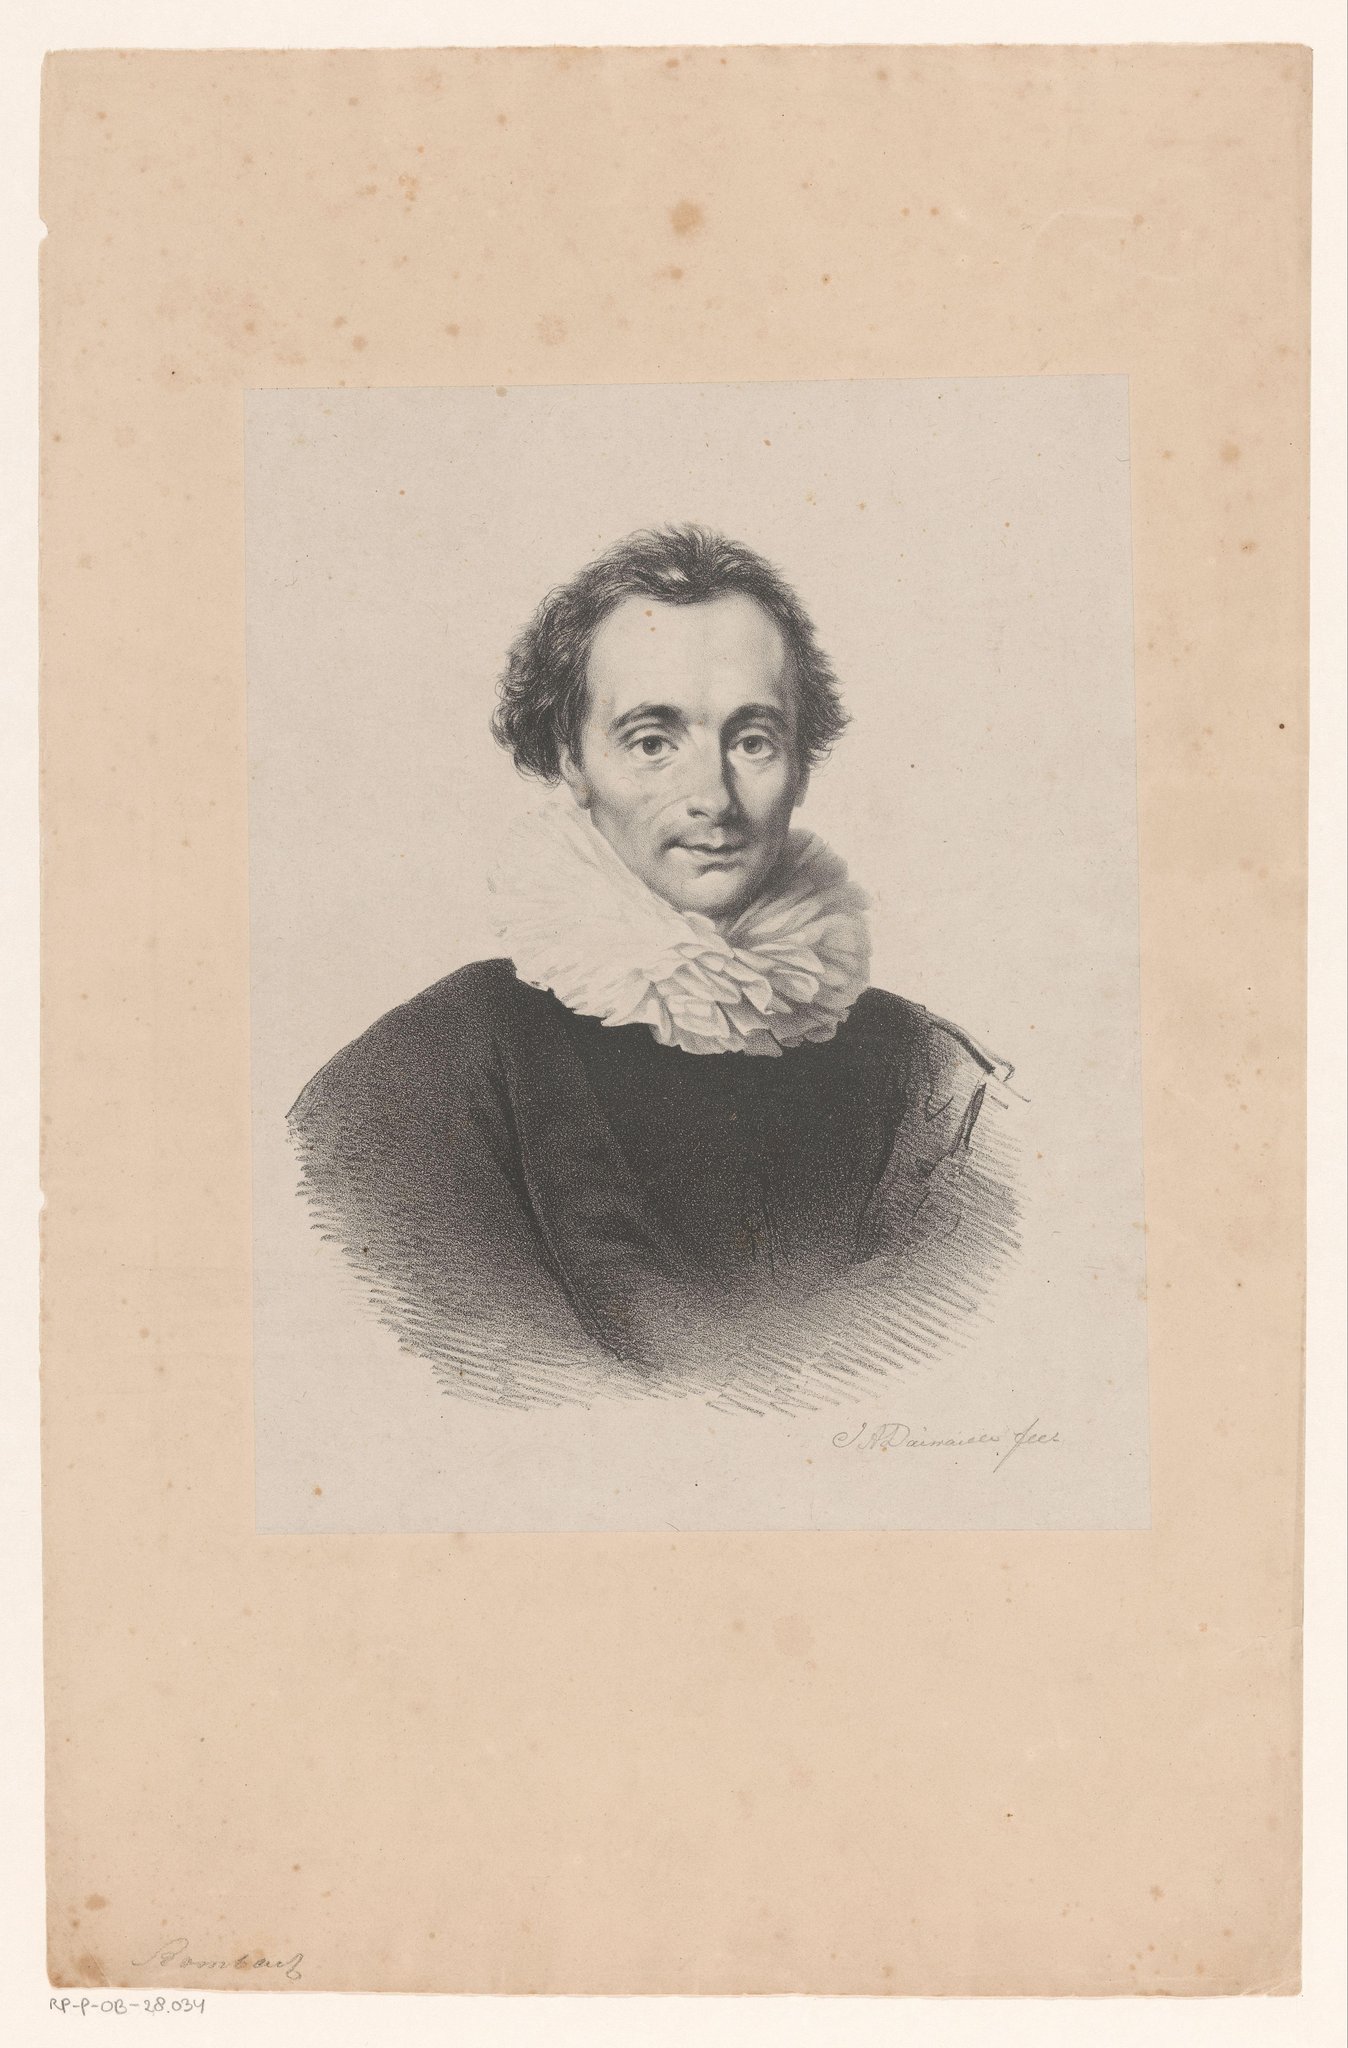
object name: print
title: Portret van een Gerard Carel Rombach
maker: jean augustin daiwaille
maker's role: draughtsman, print maker, printer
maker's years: 1786-1850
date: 1809-1850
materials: paper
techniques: lithograph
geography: amsterdam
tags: historical persons (+ (full) bust portrait), neck-gear: collar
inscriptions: collector's mark: Lugt 2228, inscription: ‘J. A. Daiwaille fecit’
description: De geportretteerde draagt een witte plooikraag en een zwarte mantel.